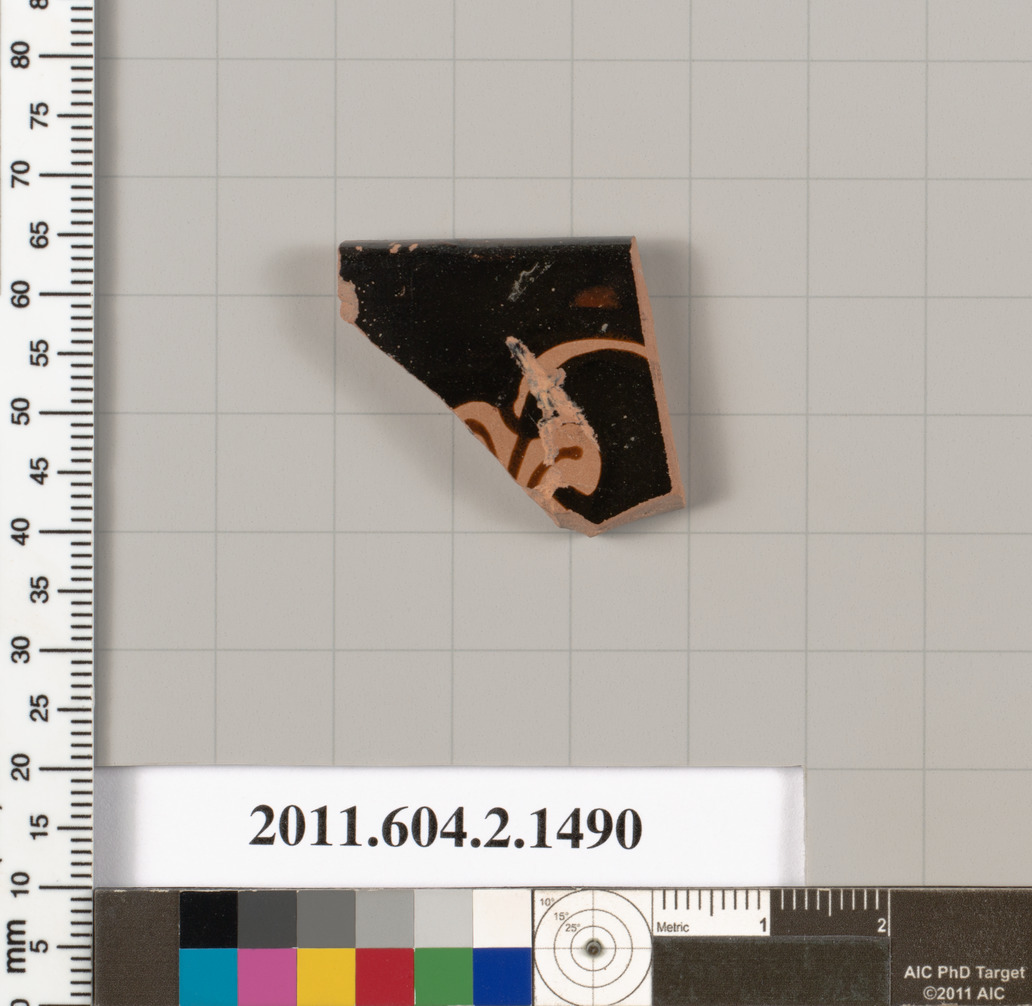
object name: skyphos fragment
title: Terracotta rim fragment of a skyphos (deep drinking cup)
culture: greek, attic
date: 450-426 BCE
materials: terracotta